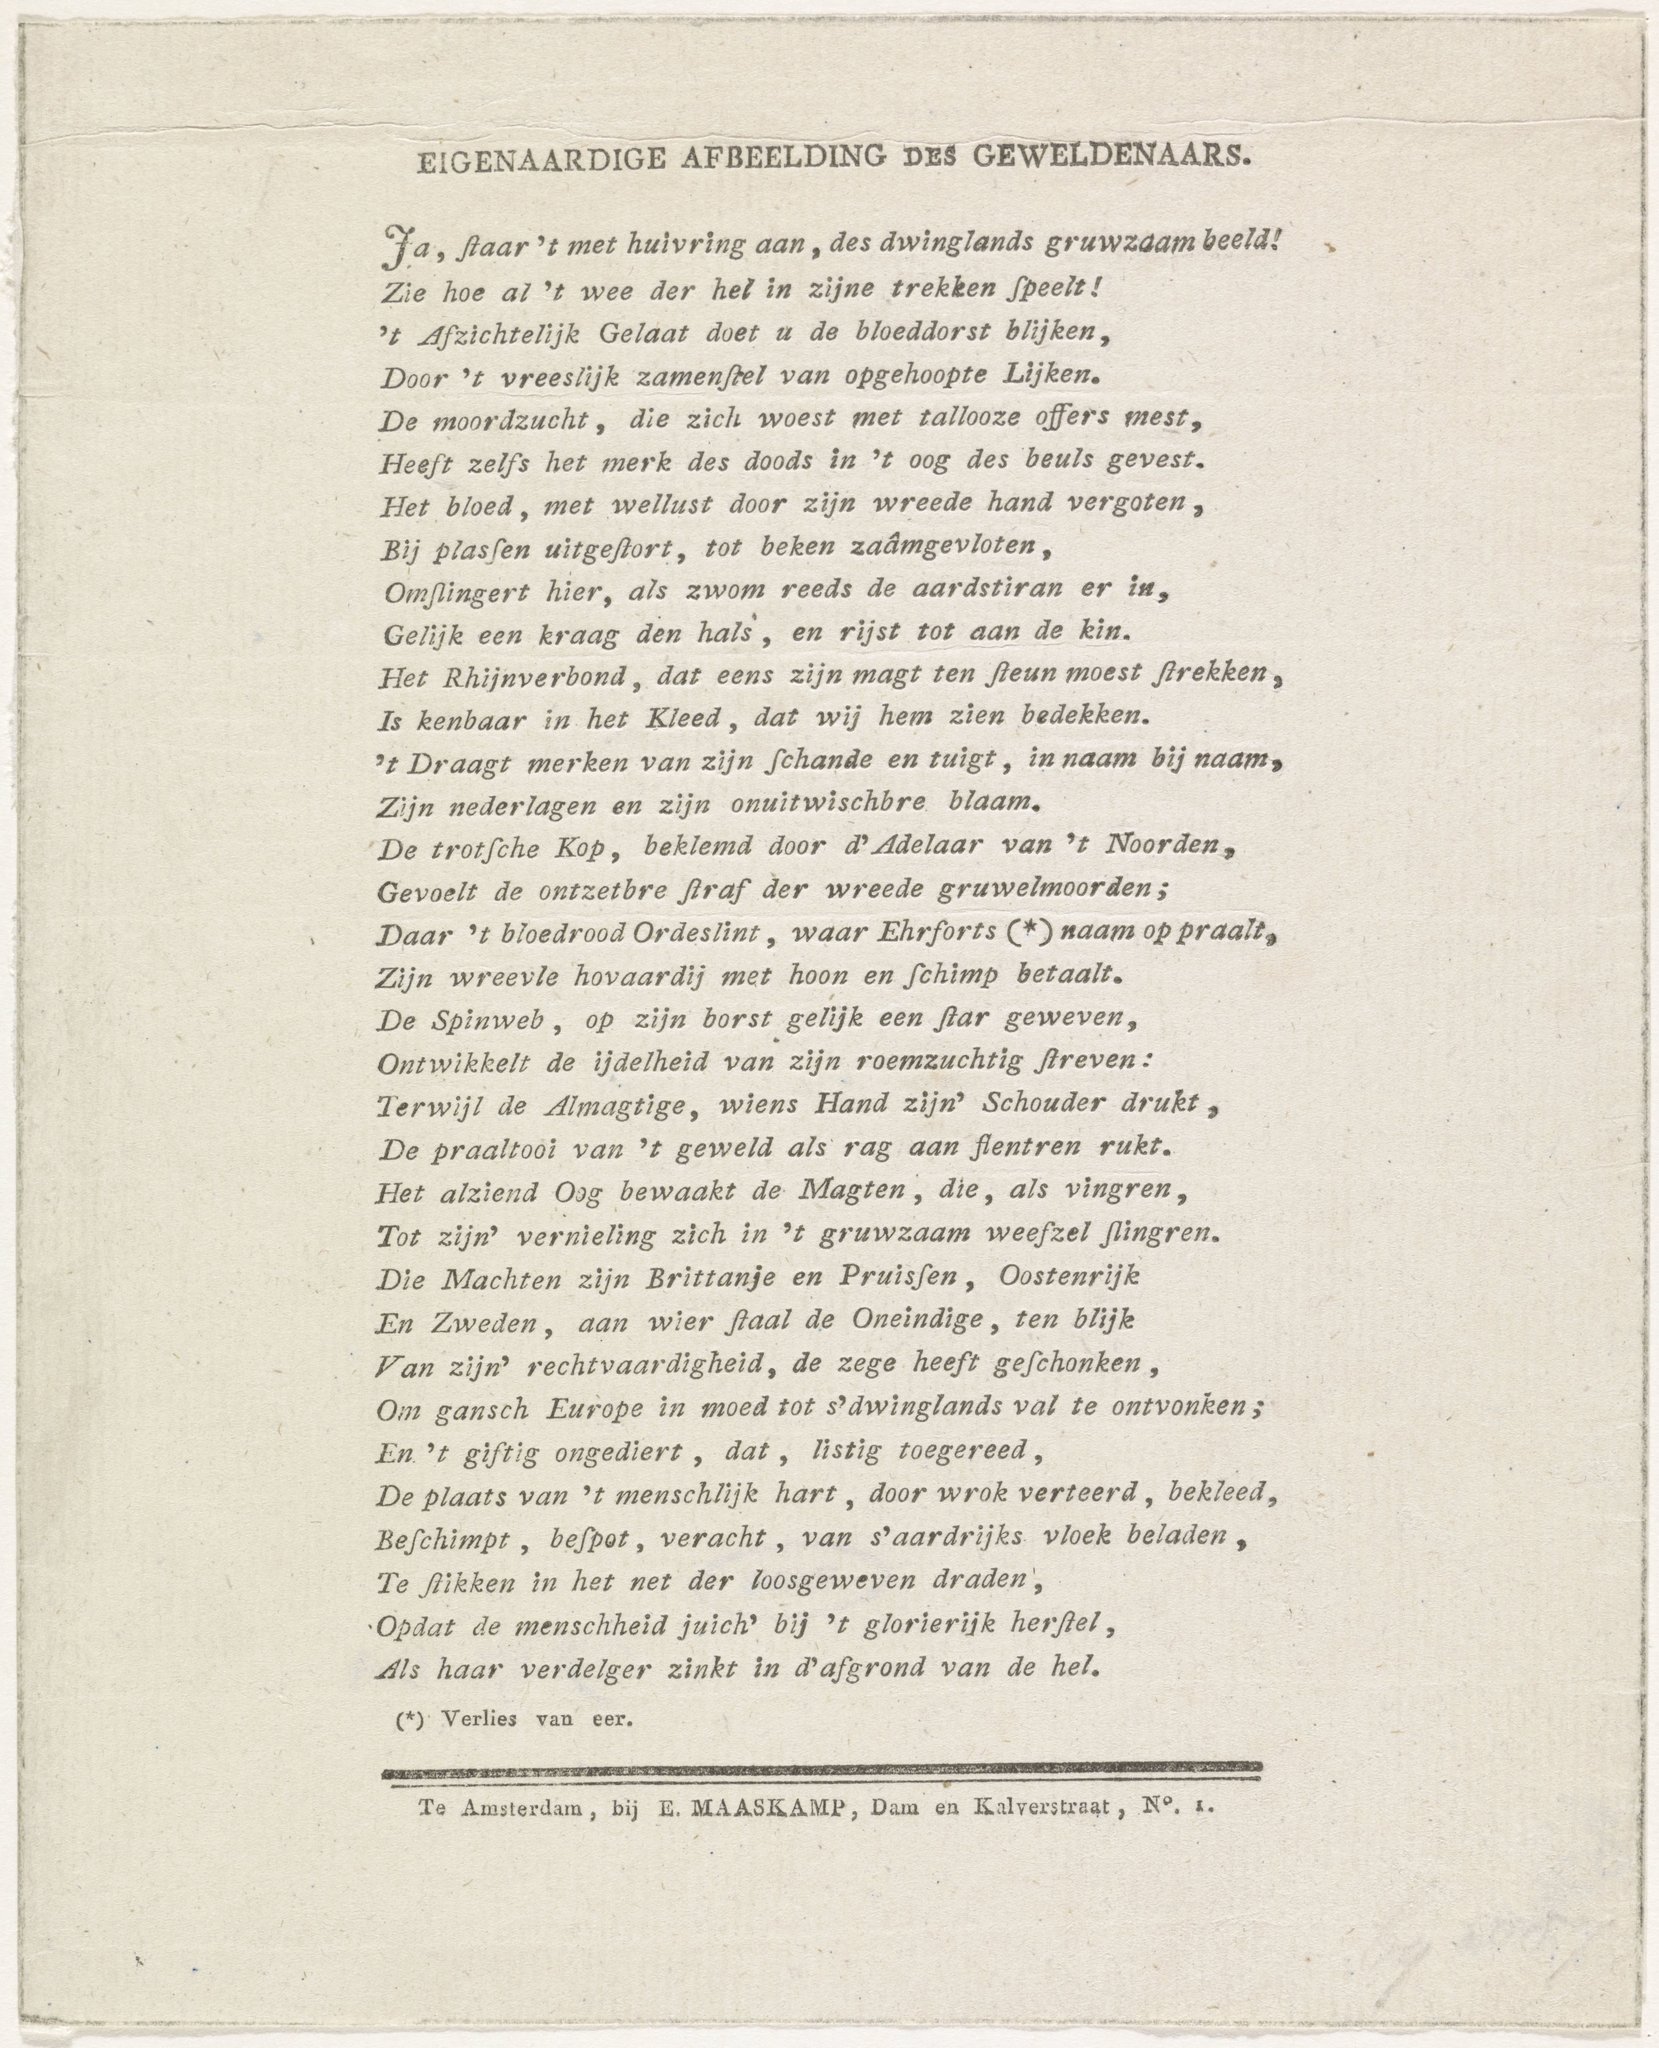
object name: cartoon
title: Vers bij de spotprent op Napoleon, 1813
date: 1813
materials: paper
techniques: letterpress printing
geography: amsterdam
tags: napoleon i (emperor of the french), political caricatures and satires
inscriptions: collector's mark: Lugt 2228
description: Tekstblad met een vers waarin de verklaring van de spotprent op Napoleon van 1813 waarbij zijn gezicht is opgebouwd uit de lijken van zijn slachtoffers.